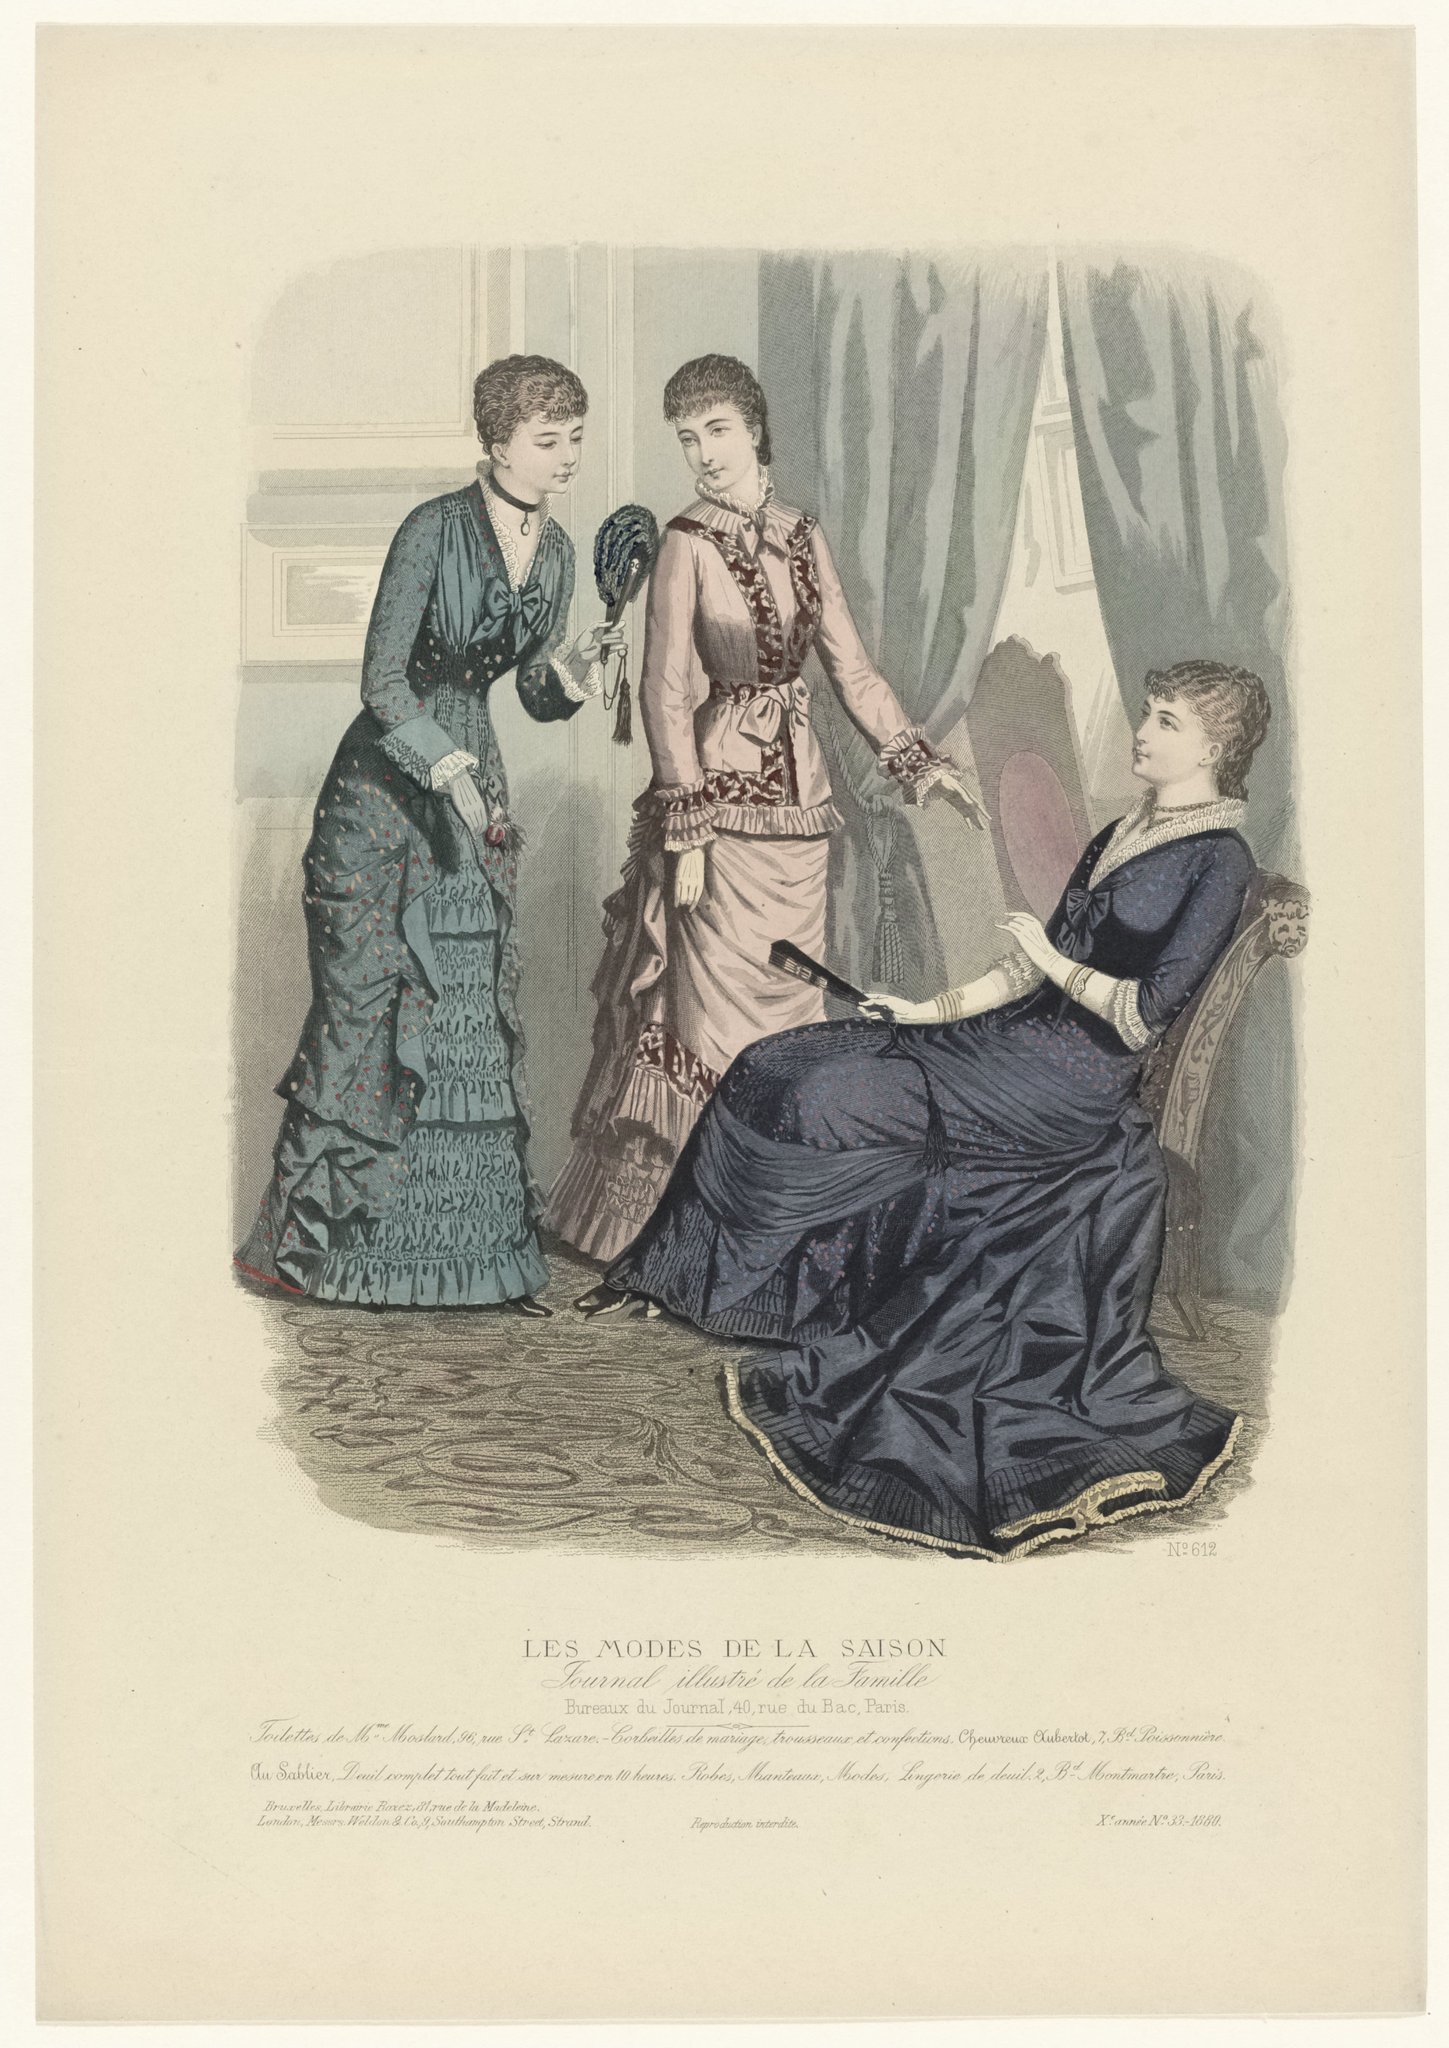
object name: fashion print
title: Les Modes de la Saison, Journal illustré de la Famille, 1880, 10e année, No. 33, No. 612: Toilettes de Mme Moslard (...)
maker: Anonymous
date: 1880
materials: paper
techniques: engraving, hand coloring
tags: pendant, trinket, 'breloque' (+ women's clothes), gloves, mittens (long gloves) (+ women's clothes), fashion plates, dress, gown (+ women's clothes), fan (+ women's clothes), bracelet, wristlet (+ women's clothes)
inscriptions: title: ‘LES MODES DE LA SAISON / Journal illustré de la Famille’, address: ‘Bureaux du Journal, 40, rue du Bac, Paris.’, address: ‘Bruxelles, Librairie Rozez, 81, rue de la Madeleine. London, Messrs. Weldon & Co, 9, Southampton Street, Strand.’, caption: ‘Toilettes de Mme Moslard, 96, rue St Lazare.- Corbeilles de mariage, trousseaux et confections. Cheuvreux Aubertot, 7, B.d Poissonnière. / Au Sablier, Deuil complet tout fait et sur mesure en 10 heures. Robes, Manteaux, modes, Lingerie de deuil, 2, Bd Montmartre, Paris.’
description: Drie vrouwen in een interieur. Volgens het onderschrift: 'toilettes' van Moslard. Hieronder enkele regels reclametekst voor verschillende producten. Prent uit het modetijdschrift Les Modes de la Saison (1871-1885).